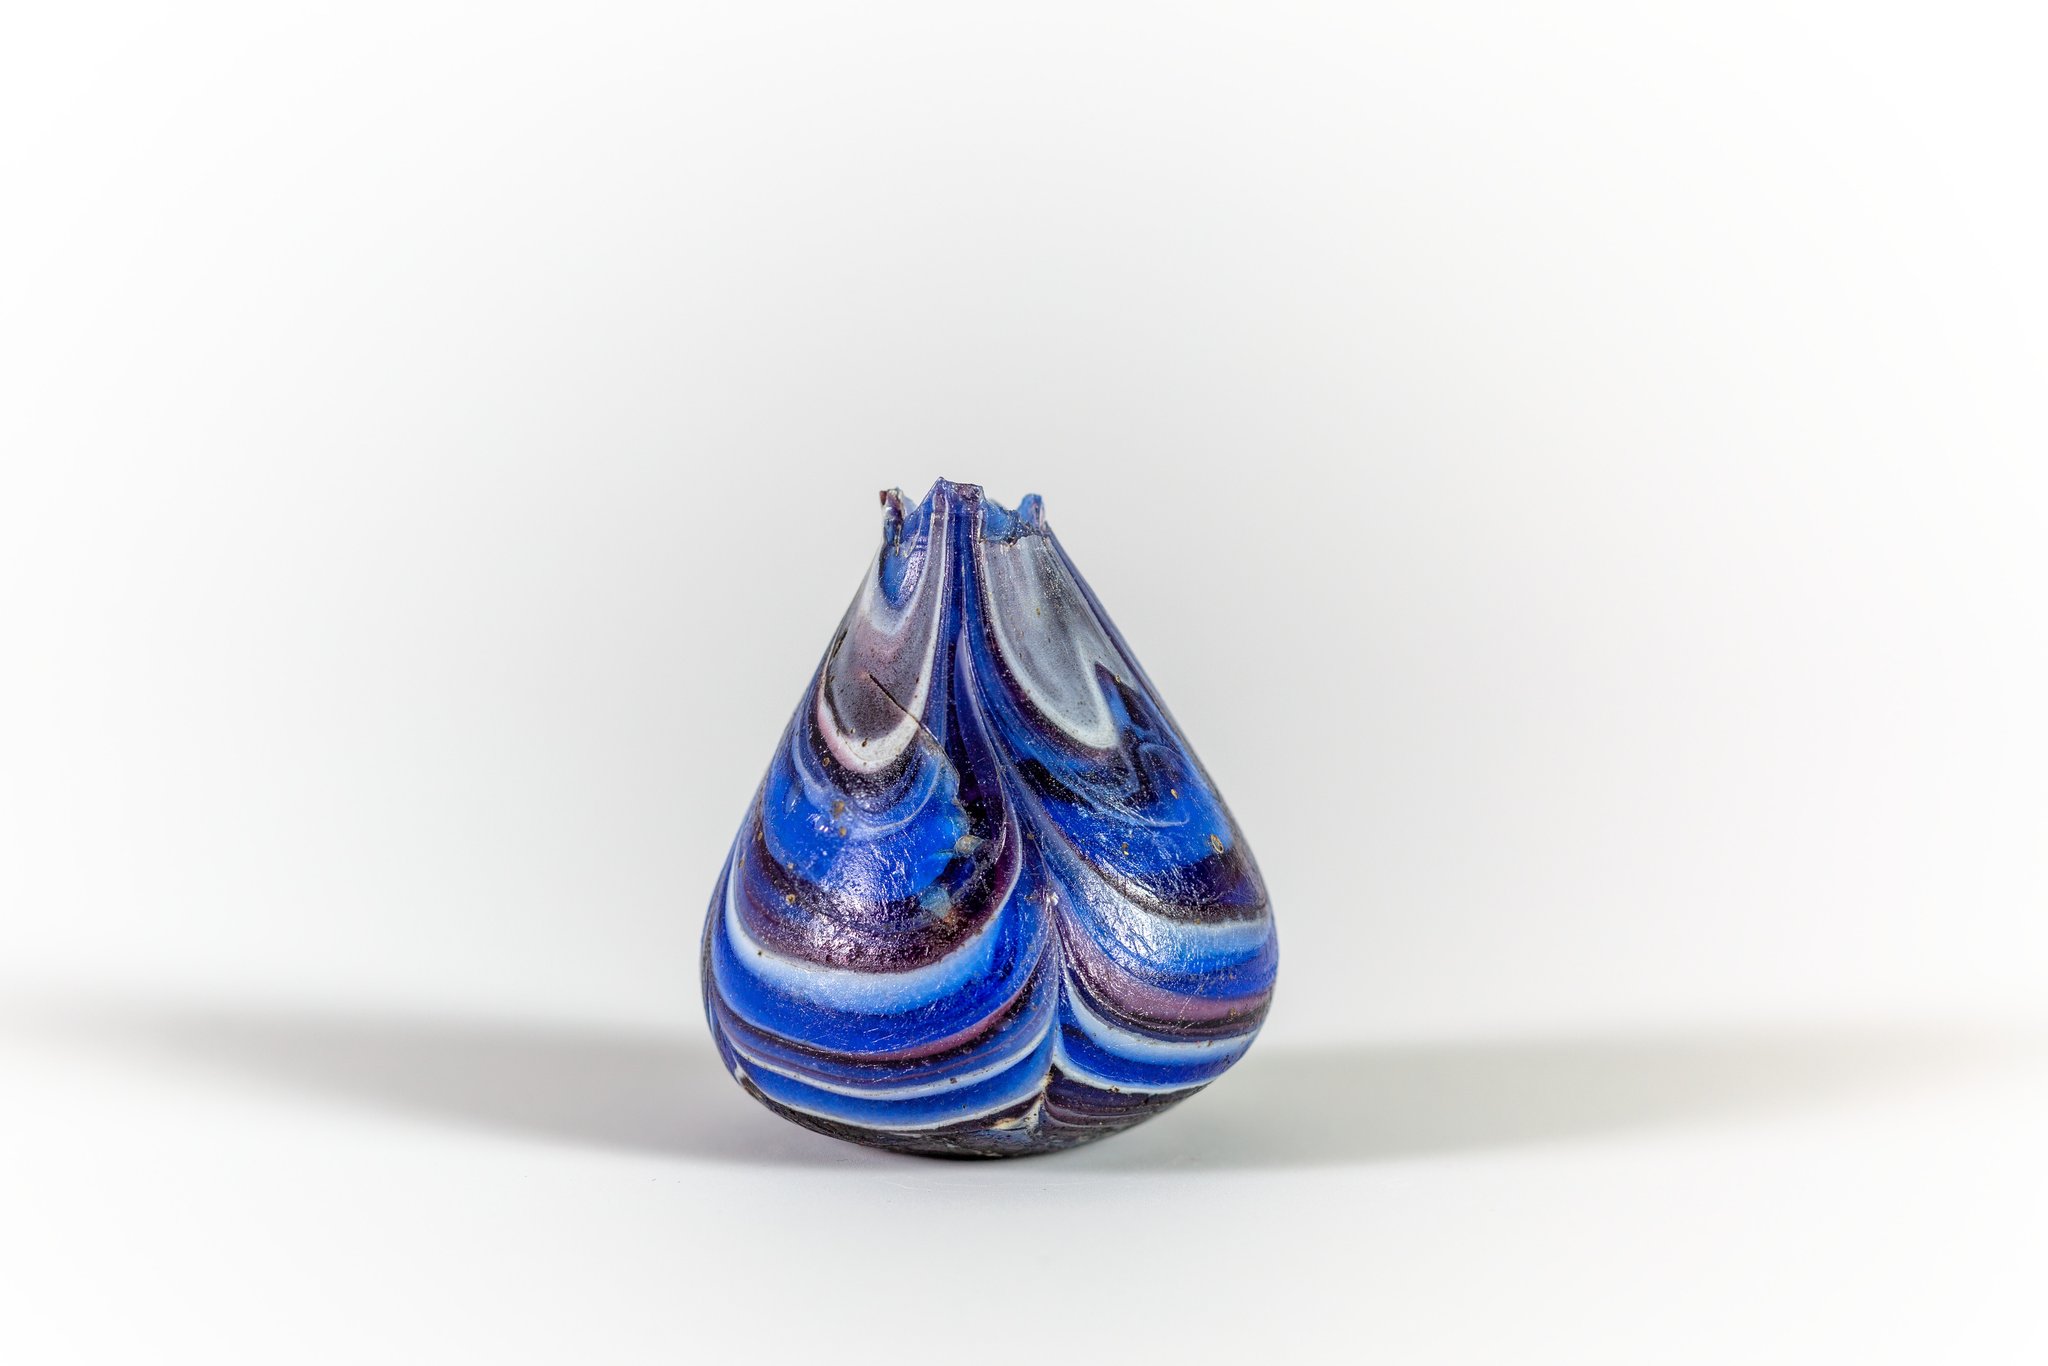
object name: perfume bottle, mosaic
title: Glass mosaic perfume bottle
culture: roman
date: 1-100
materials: glass